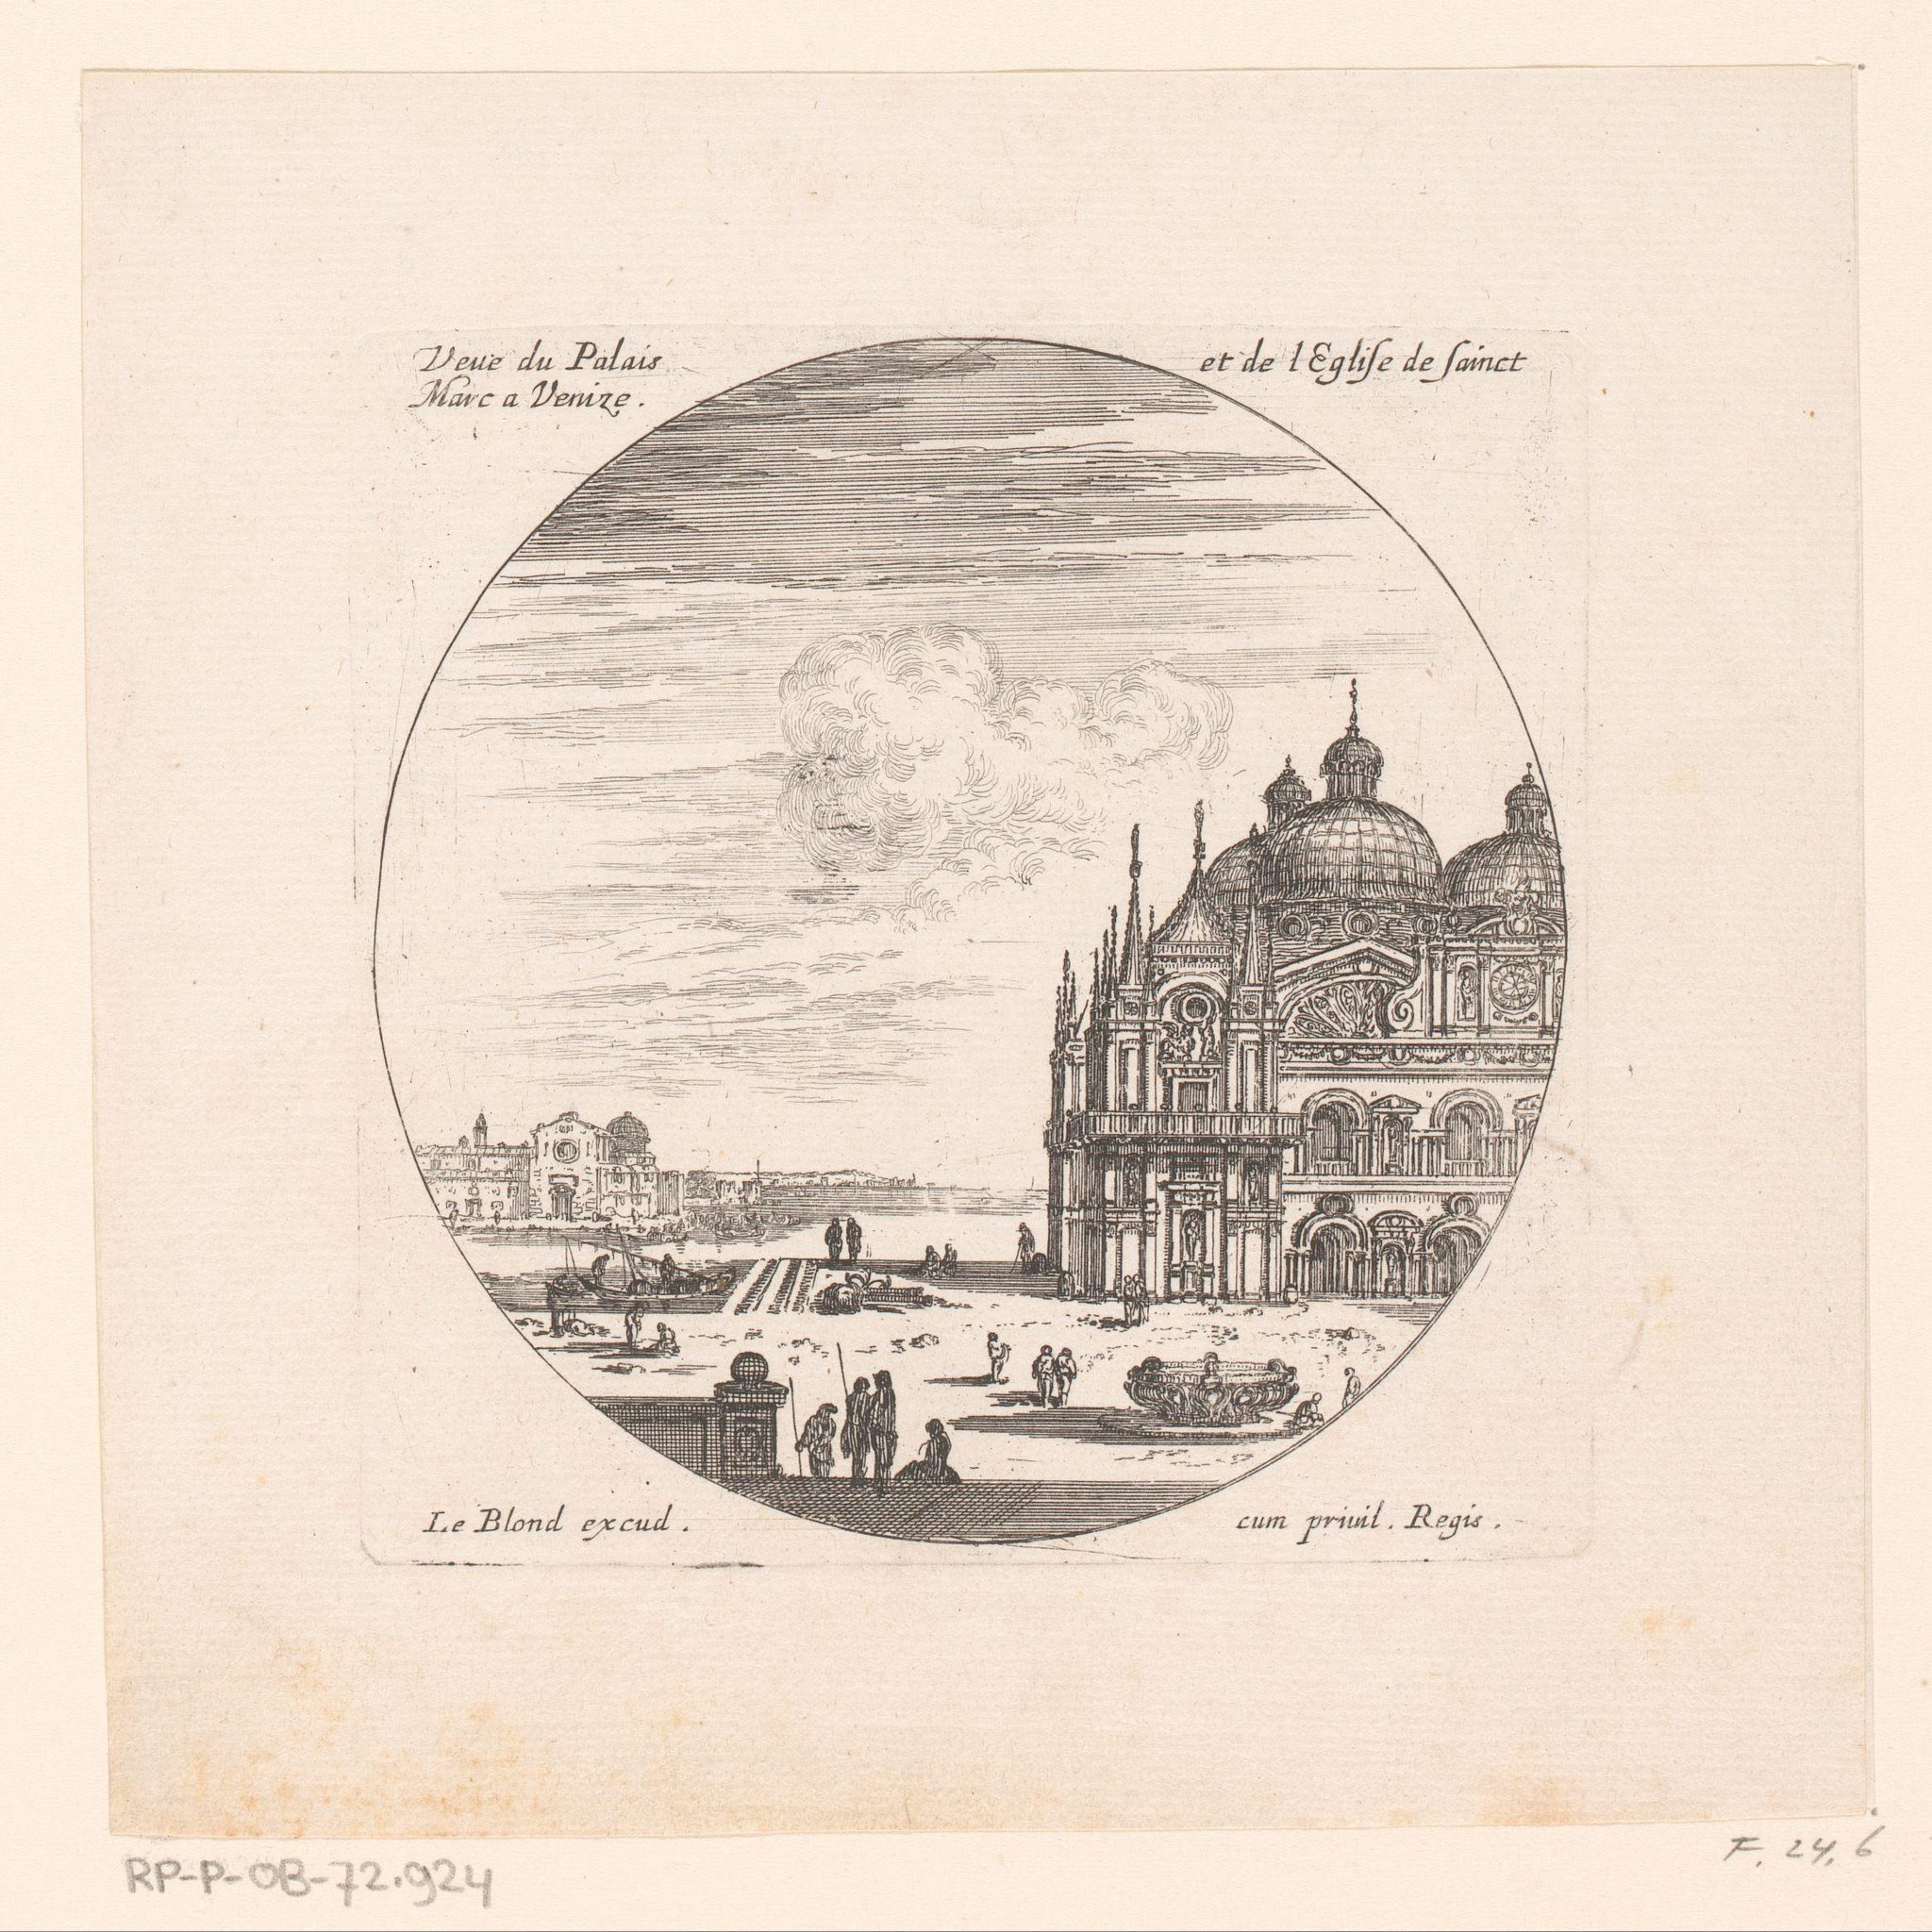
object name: print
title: Veue du Palais et de l'Eglise de Sainct Marc a Venize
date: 1645-1691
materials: paper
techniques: etching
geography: france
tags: church (exterior), city-view, and landscape with man-made constructions (+ city(-scape) with figures, staffage)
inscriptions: collector's mark: Lugt 240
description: Prent maakt deel uit van een ongenummerde serie van zes prenten.